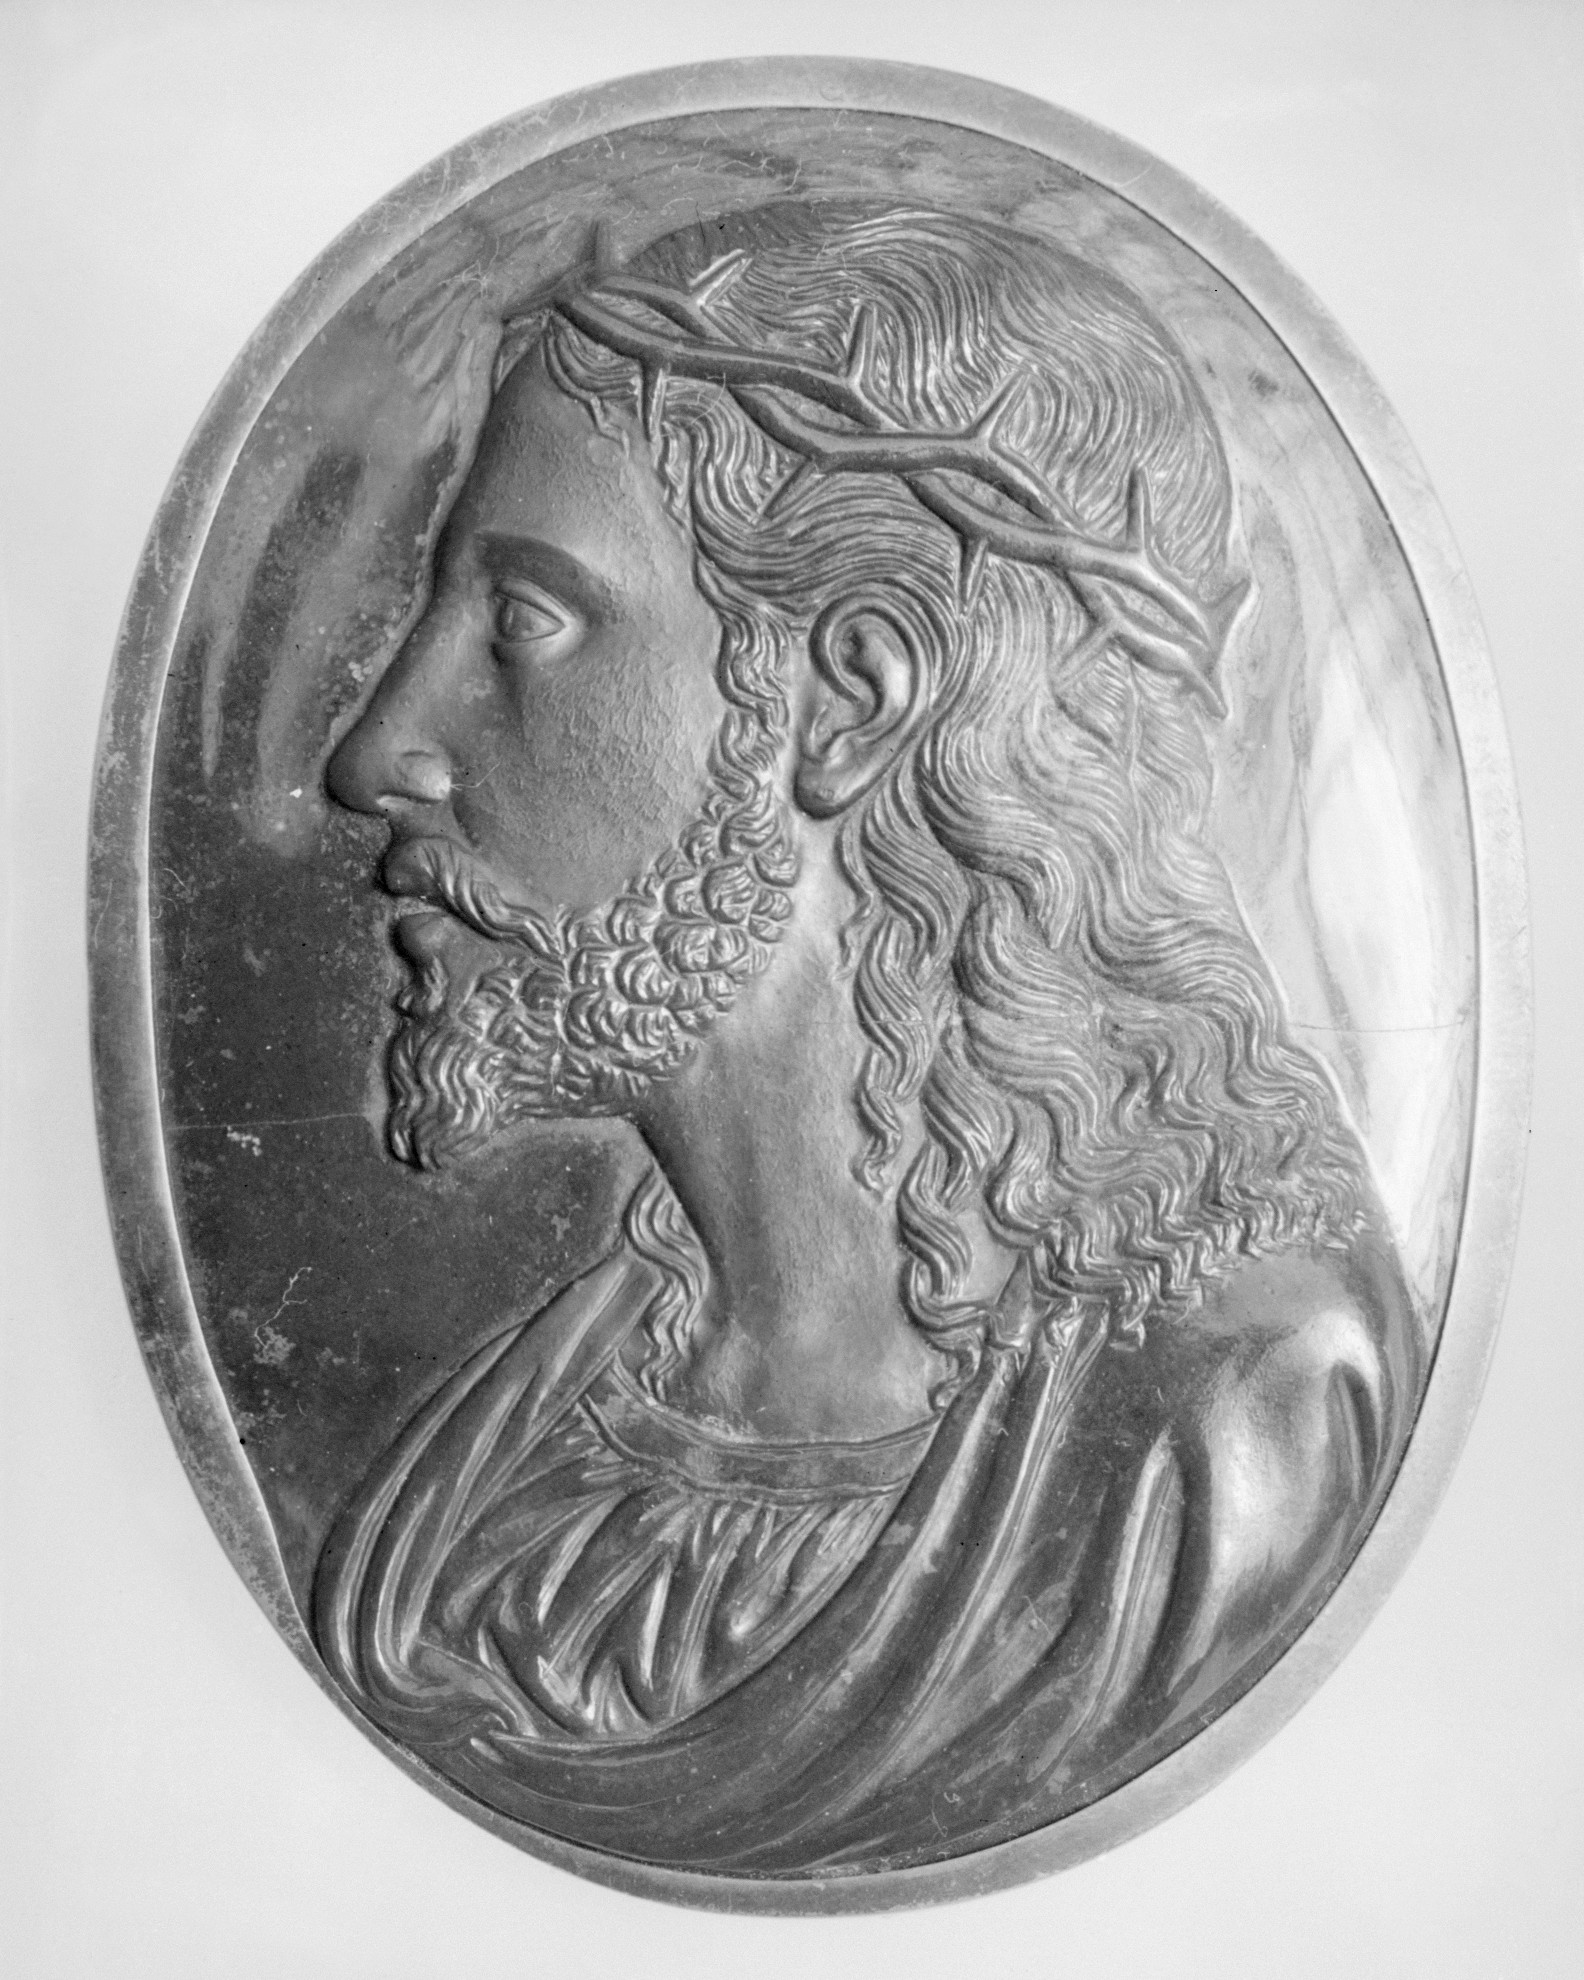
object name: cameo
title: Head of Christ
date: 1501-1700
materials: silver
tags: profiles,christ